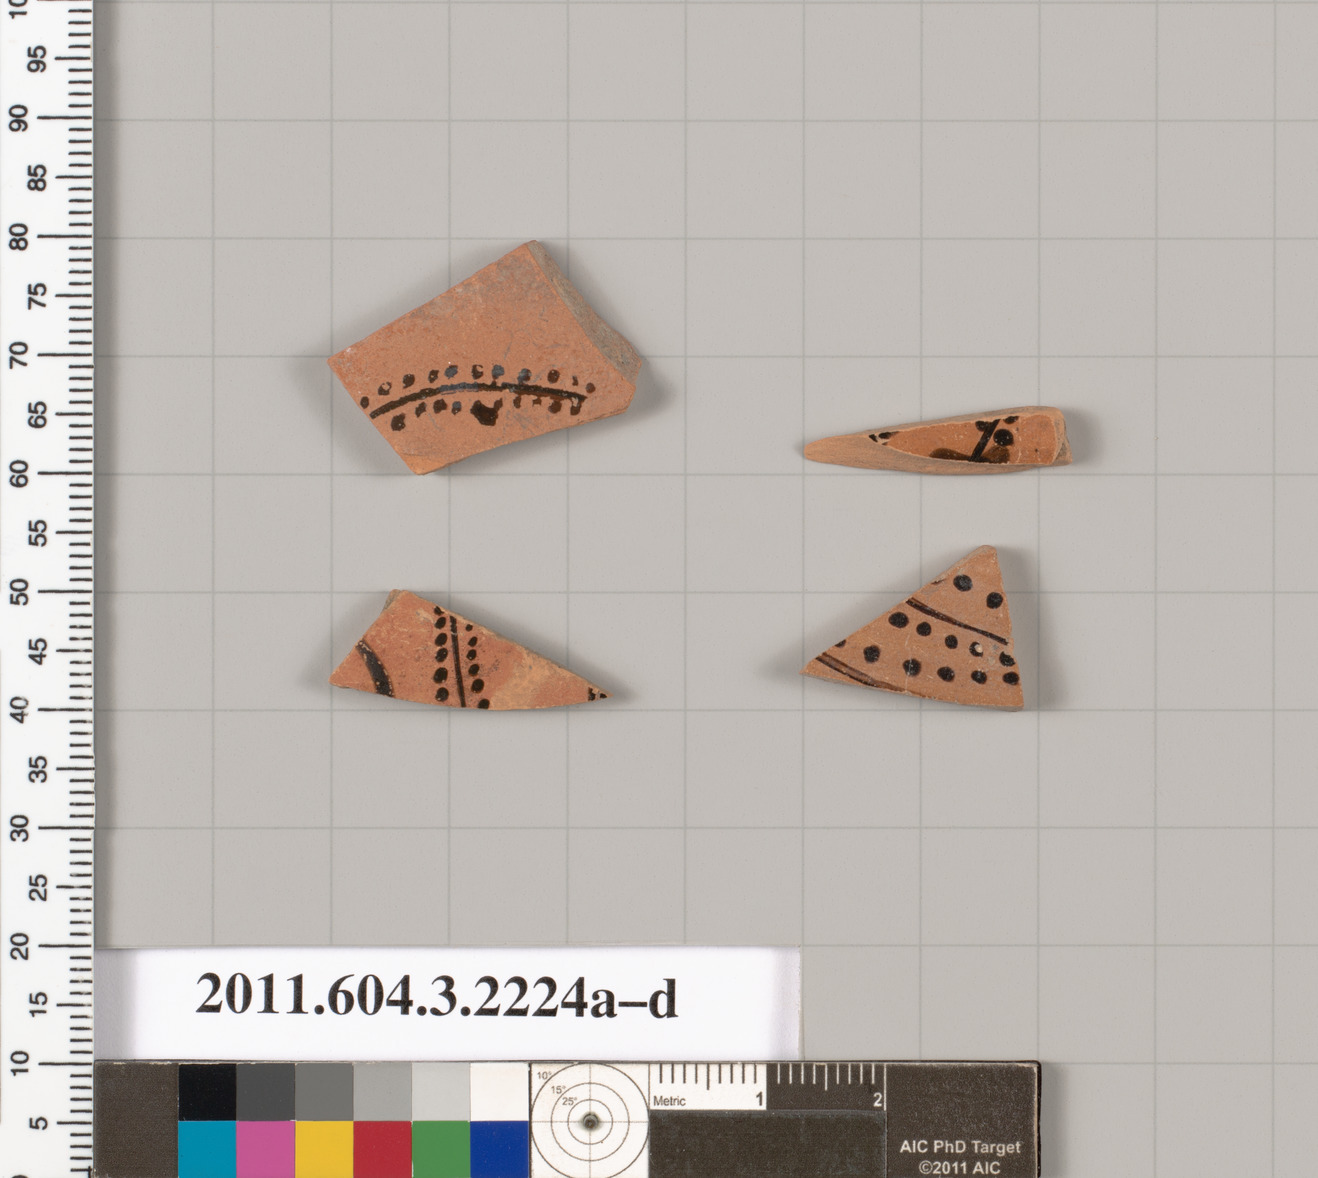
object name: kylix fragment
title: Terracotta fragments of kylikes (drinking cups)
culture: greek, attic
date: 600-401 BCE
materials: terracotta